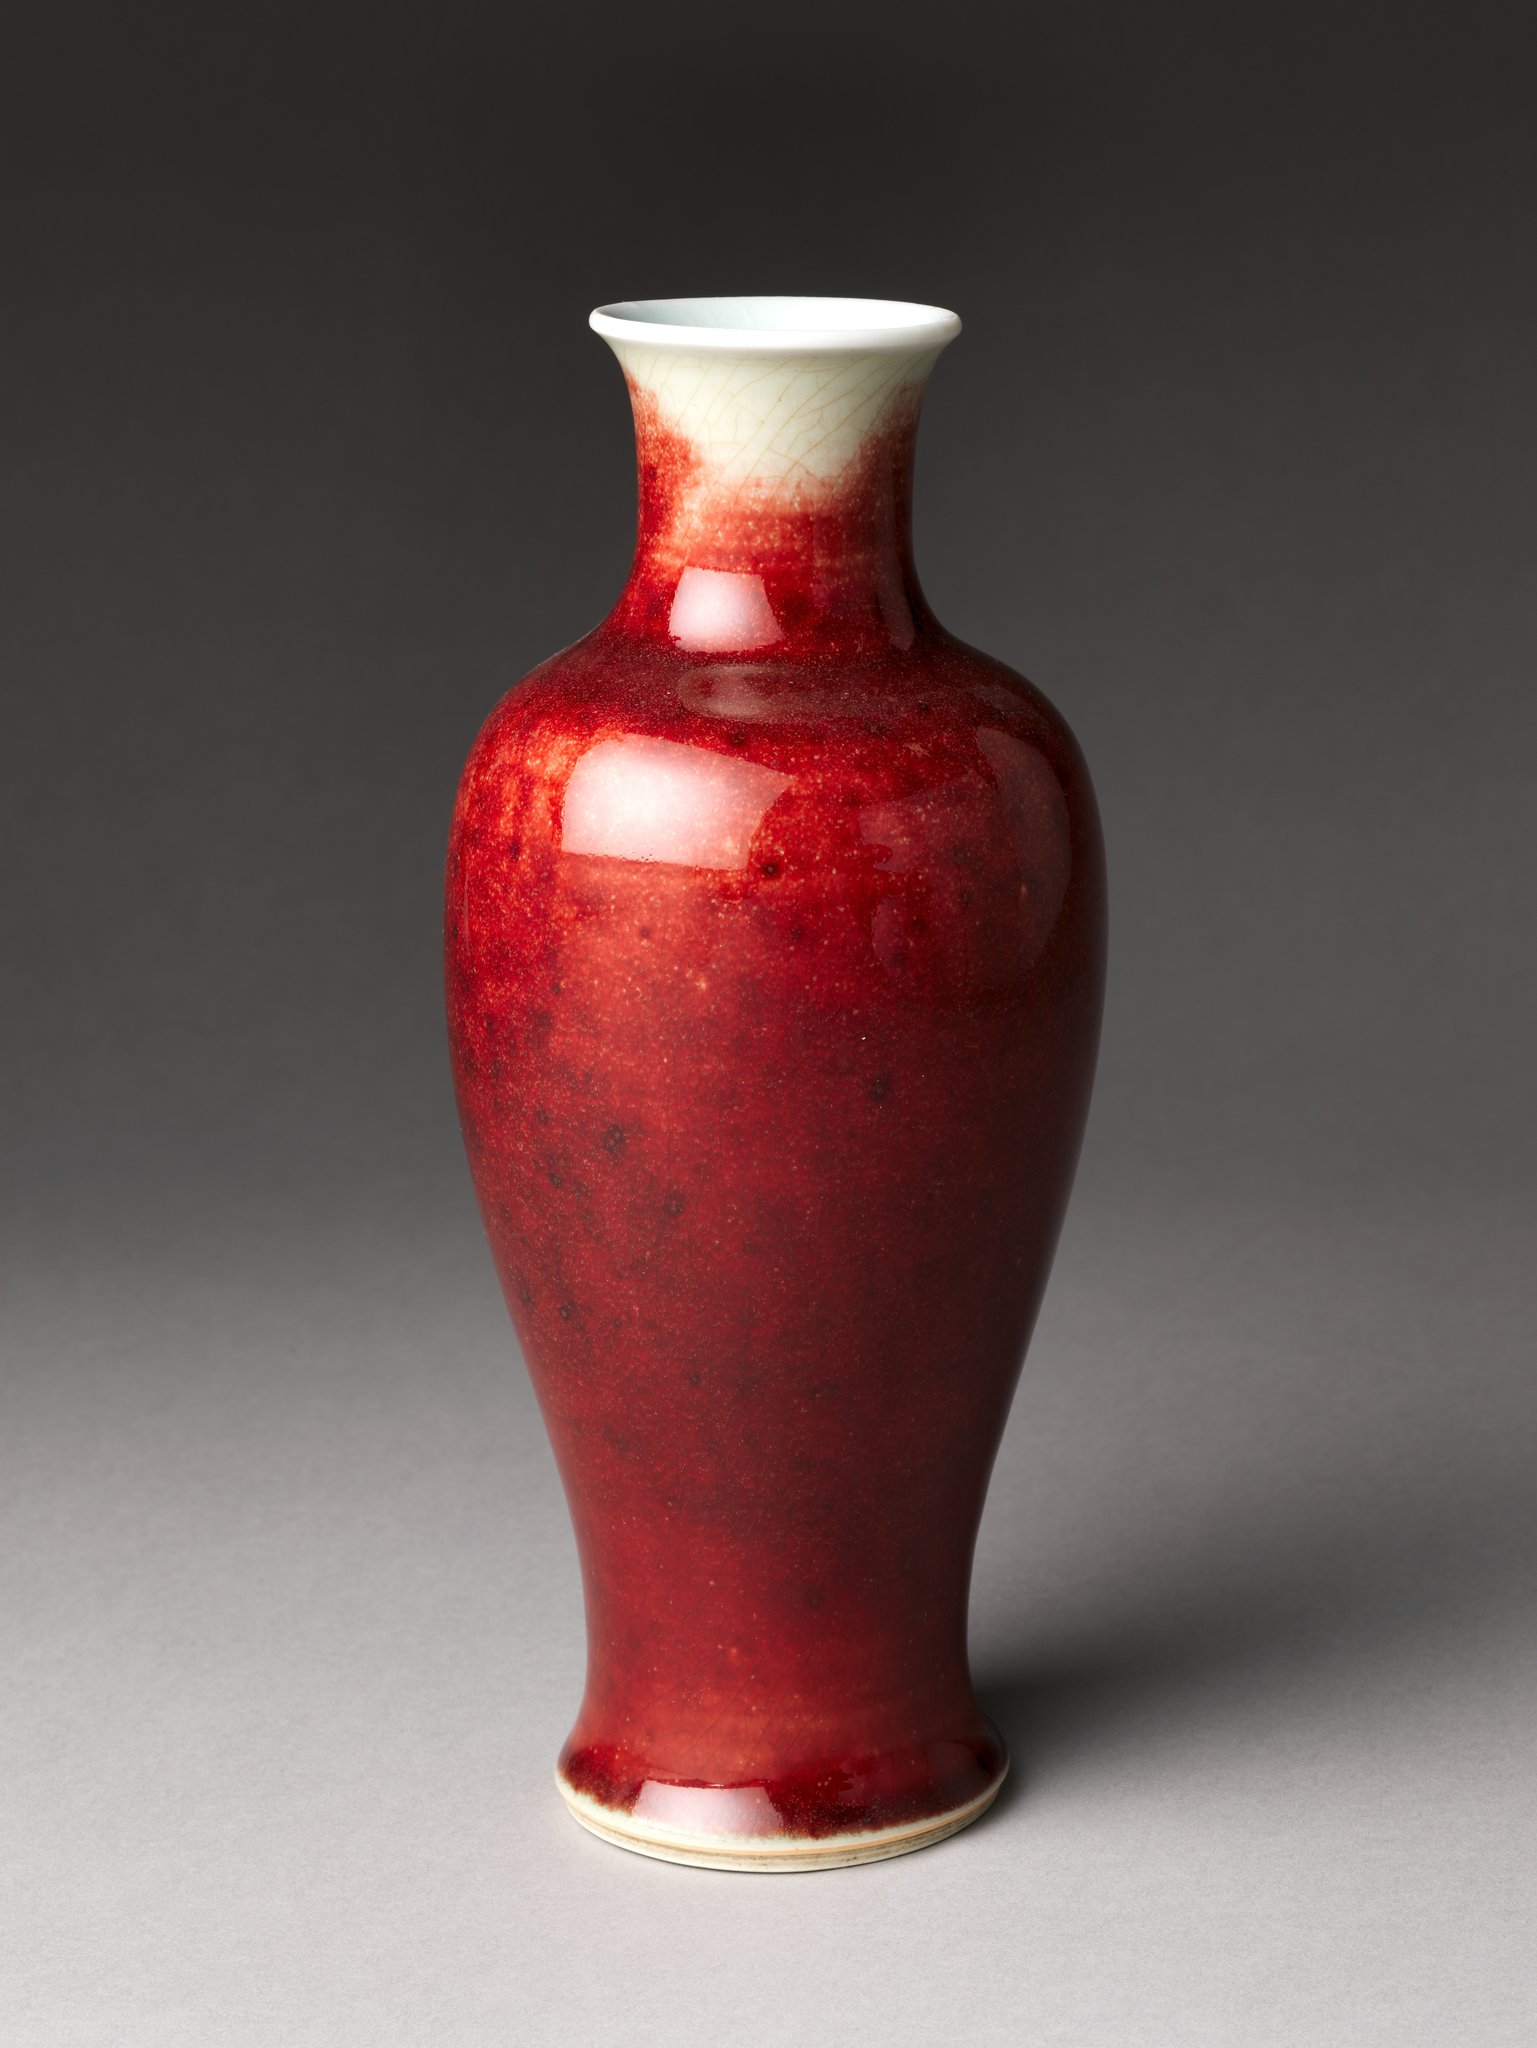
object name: vase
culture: chinese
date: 1667-1733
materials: glaze, porcelain